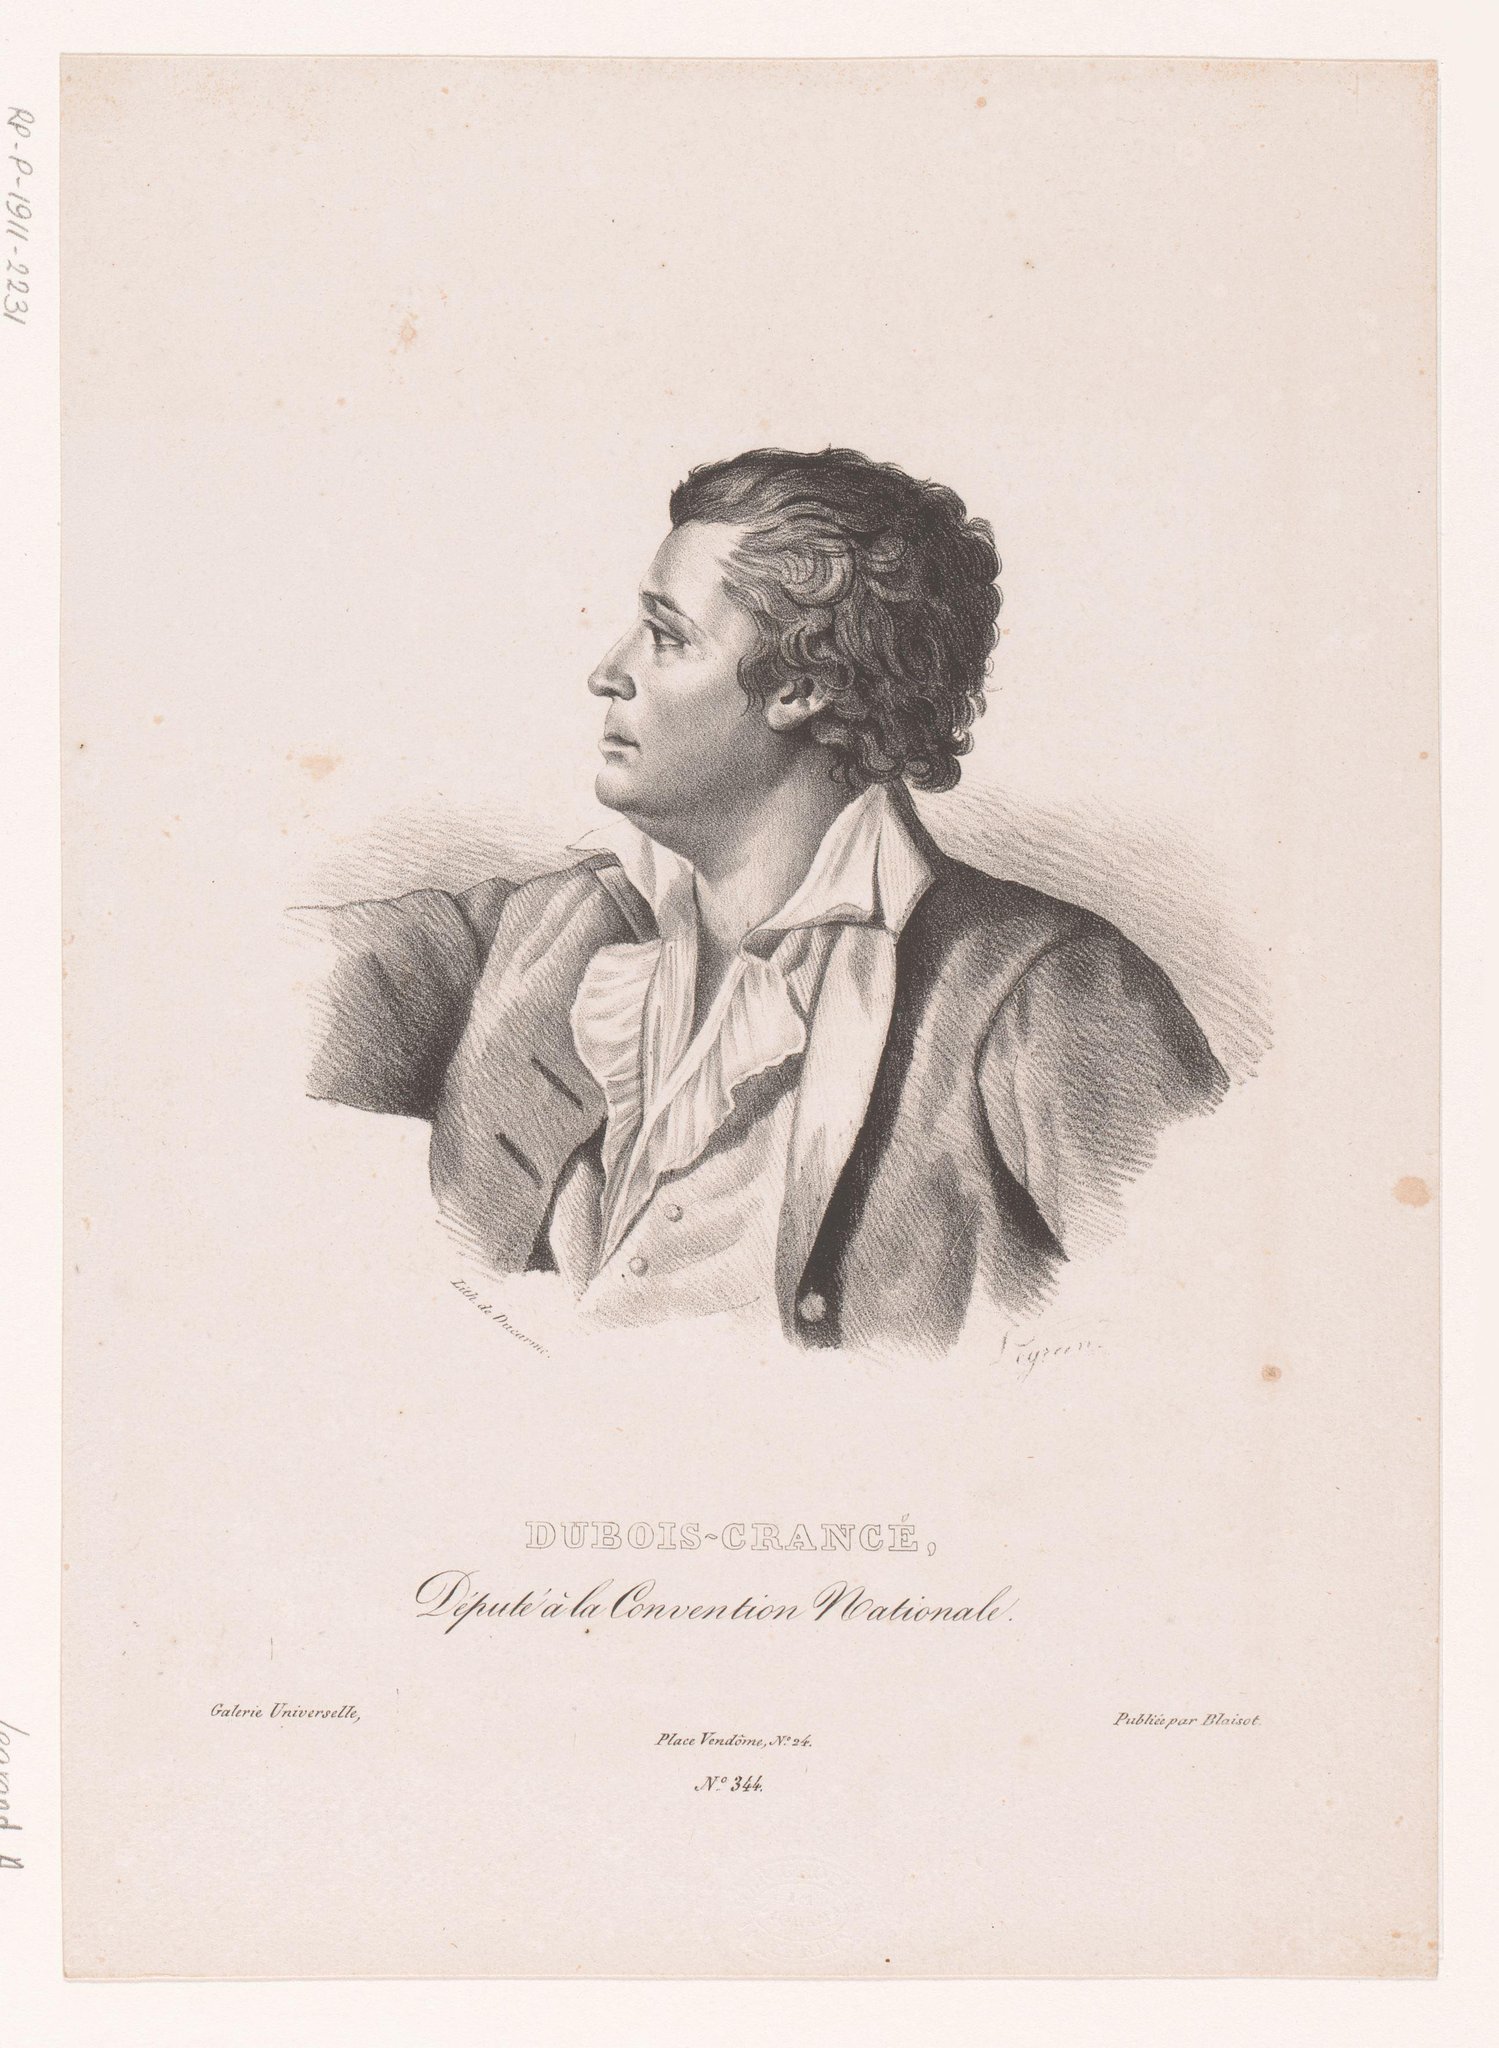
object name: print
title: Portrettengalerij van Blaisot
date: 1827-1829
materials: paper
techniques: lithograph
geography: paris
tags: politician, historical persons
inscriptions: check stamp: Lugt 5415, collector's mark: Lugt 2228a